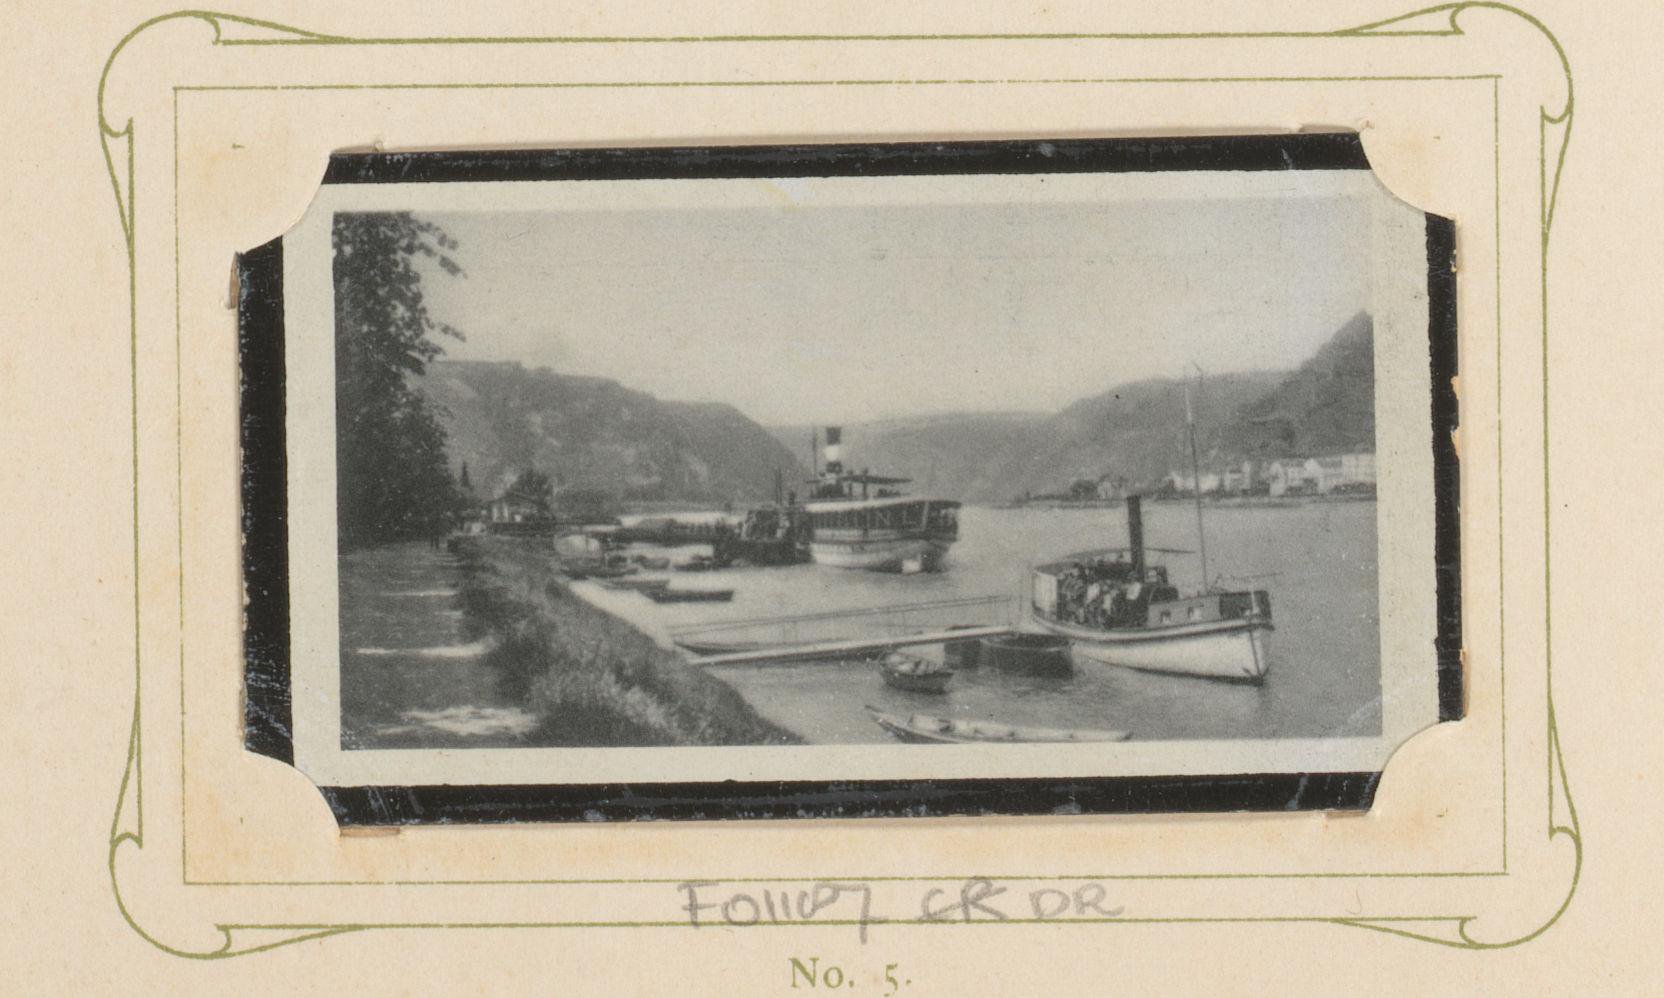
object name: photomechanical print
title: Gezicht op Sankt Goar, Duitsland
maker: Anonymous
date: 1905-1906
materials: paper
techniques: photograph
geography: sankt goar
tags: prospect of village, silhouette of village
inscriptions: inscription: ‘No. 5./ Sankt Goar.’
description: Deze prent maakt deel uit van een album.